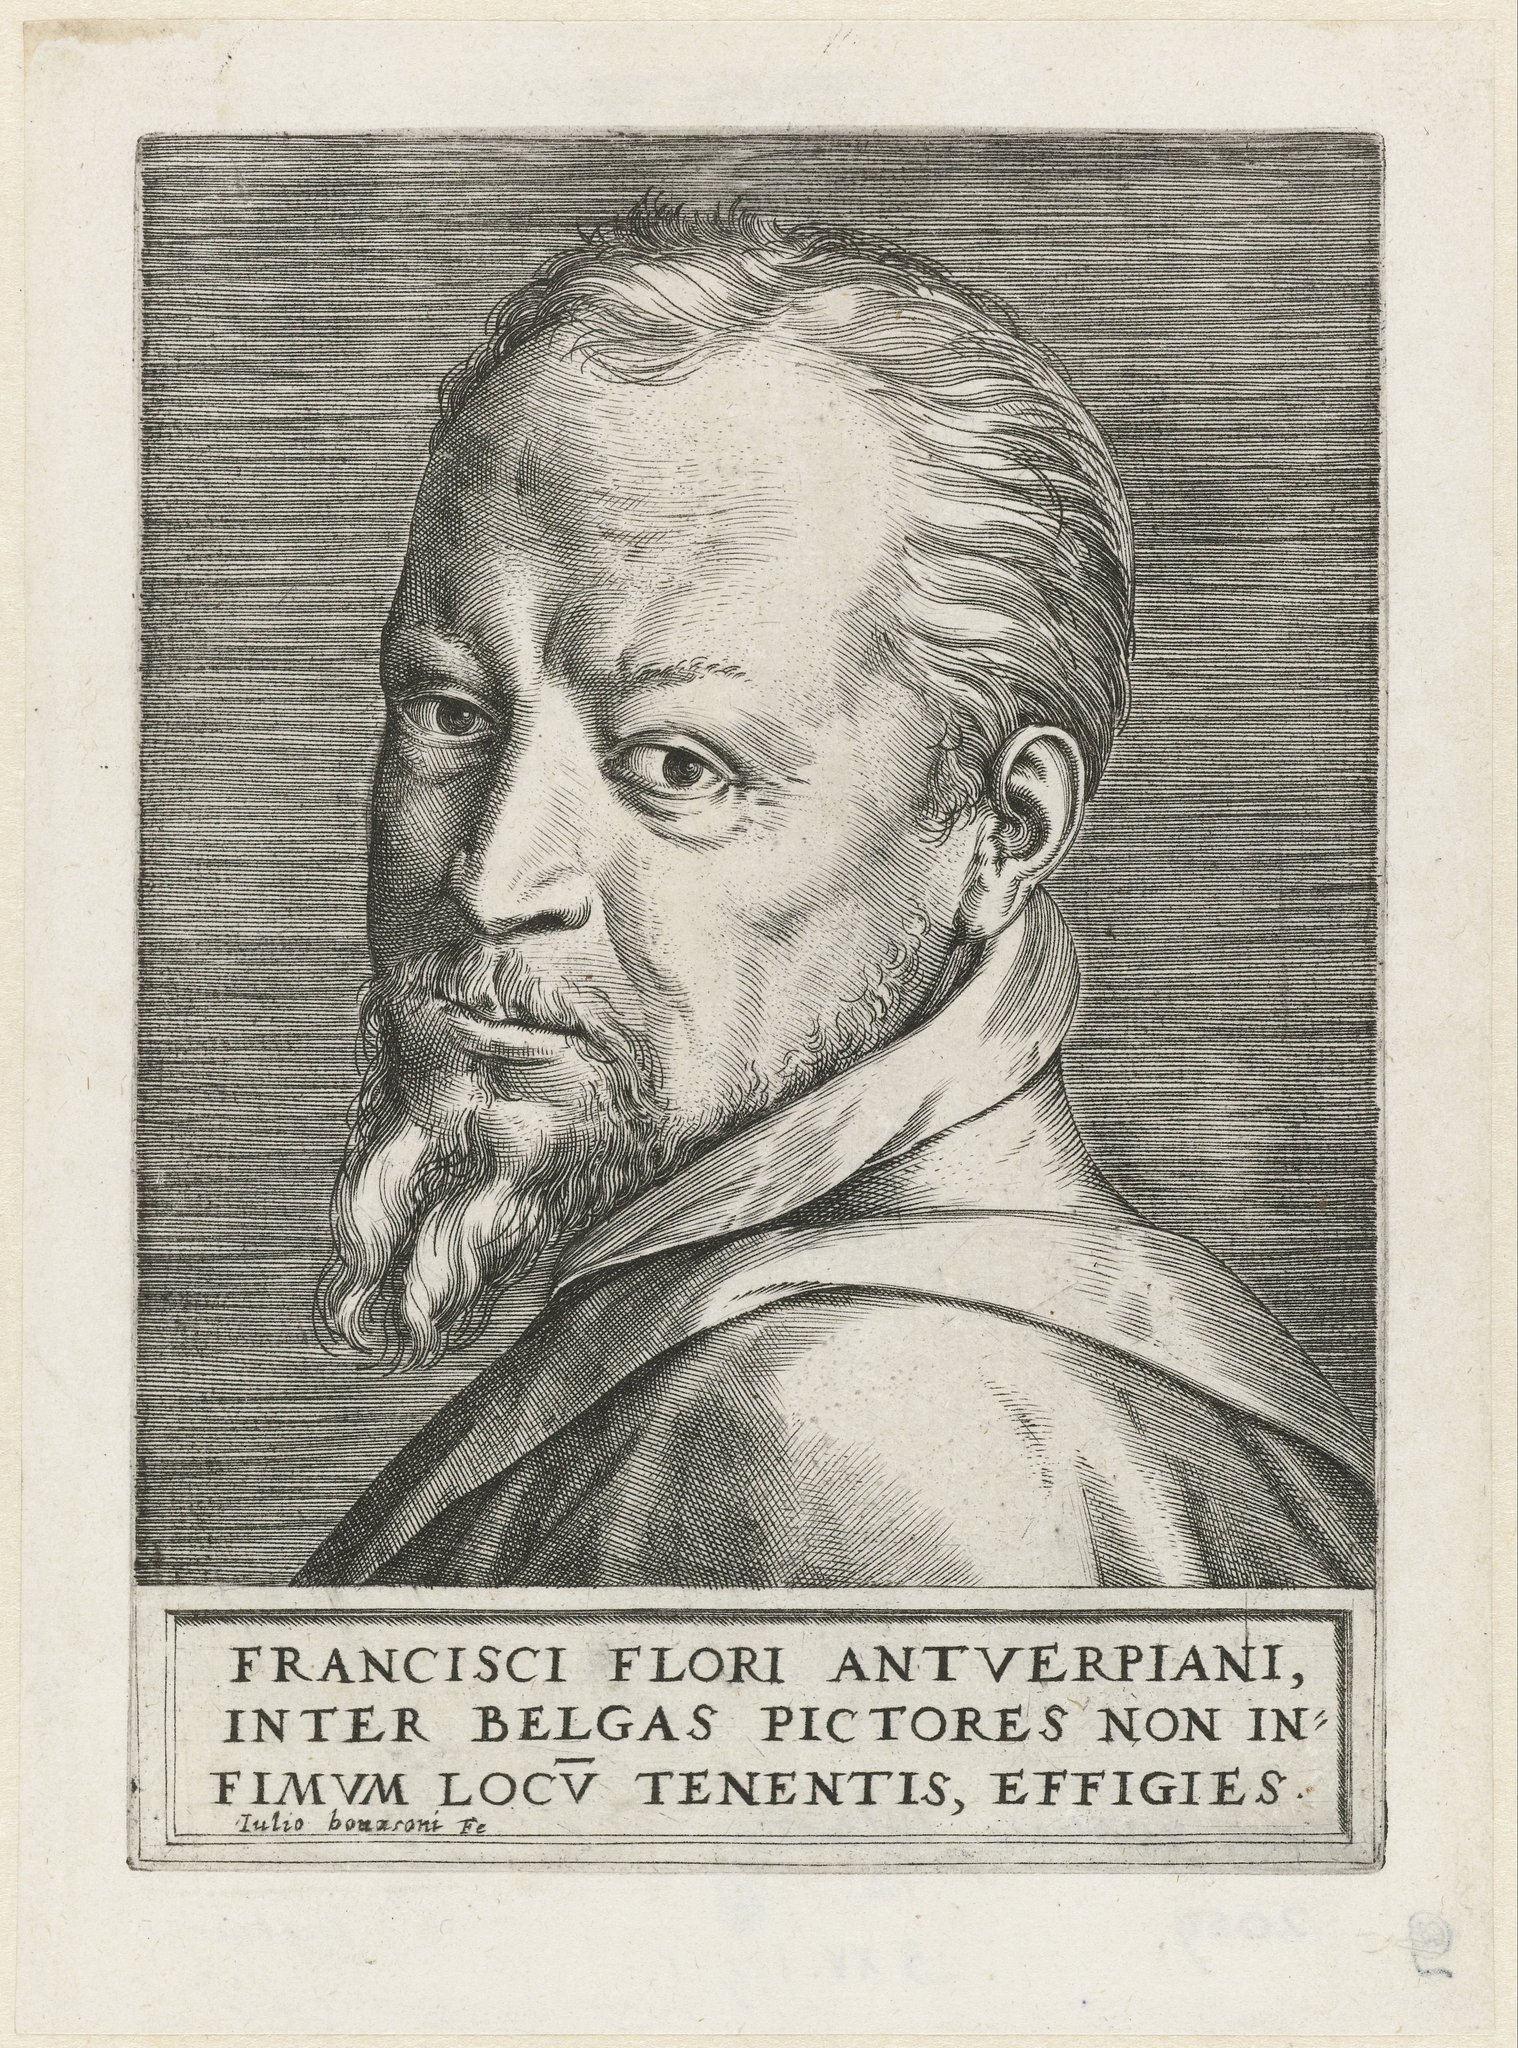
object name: print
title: Portret van de kunstenaar Frans Floris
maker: giulio bonasone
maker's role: painter, print maker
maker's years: 1510-1576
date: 1501-1580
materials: paper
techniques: engraving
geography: italy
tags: print maker, draughtsman, frans floris (i), historical persons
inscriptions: collector's mark: ‘G C A B’, collector's mark: Lugt 2760, collector's mark: Lugt 2228